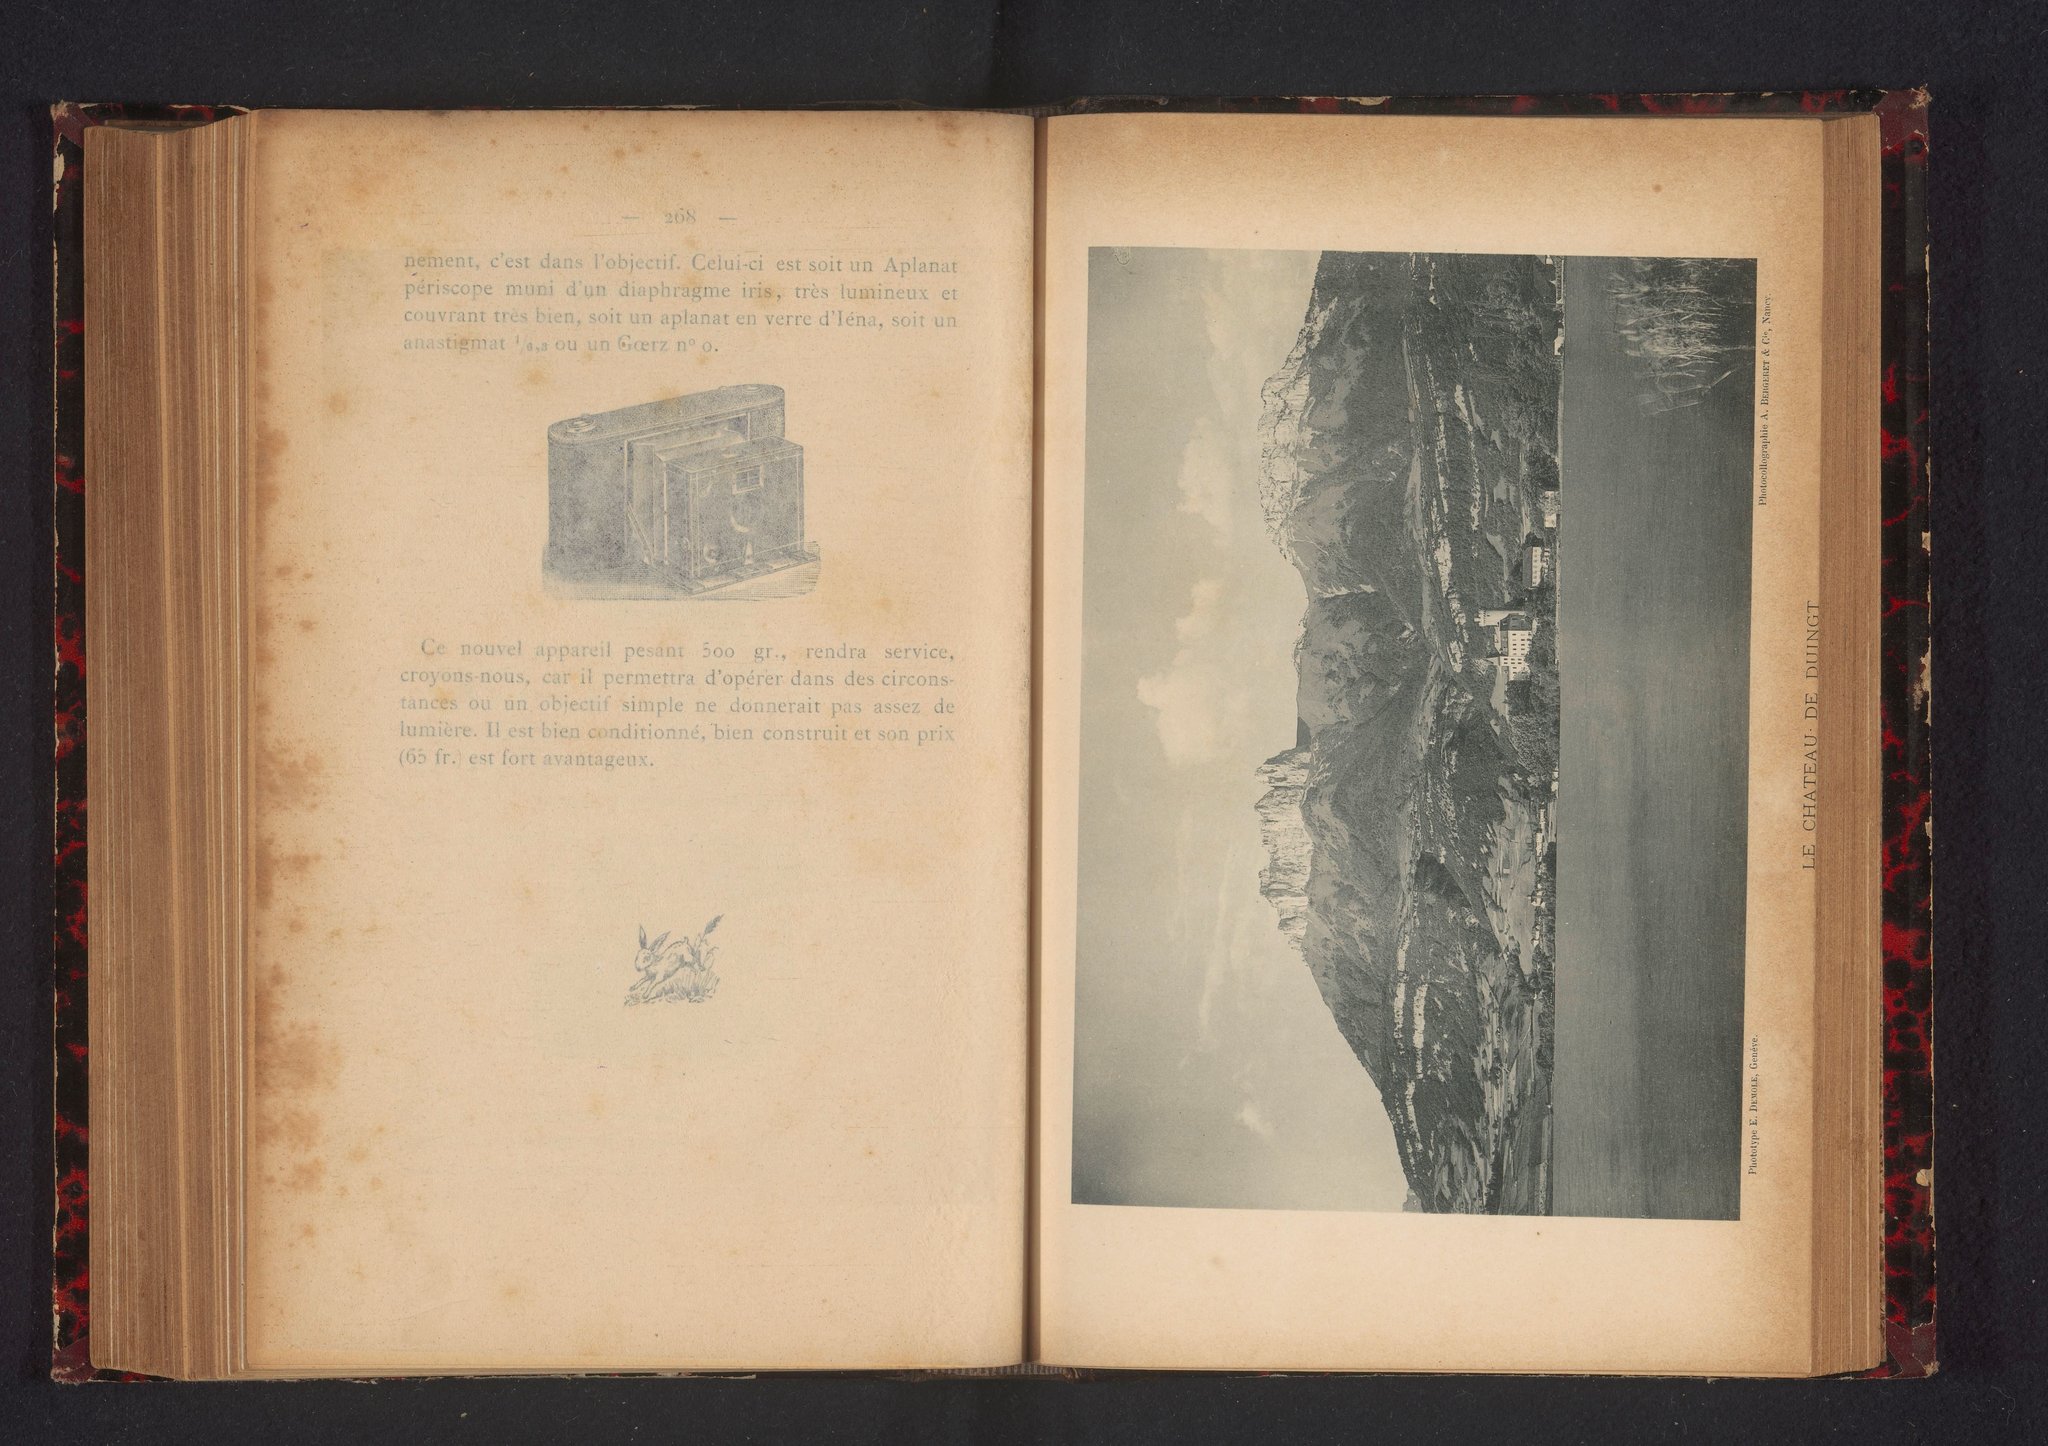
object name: page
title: Gezicht op Château de Duingt in Frankrijk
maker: eugène demole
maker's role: conservator, fotograaf, numismaat, scheikundige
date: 1893-1898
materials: paper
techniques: photograph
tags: castle, lake, mountains